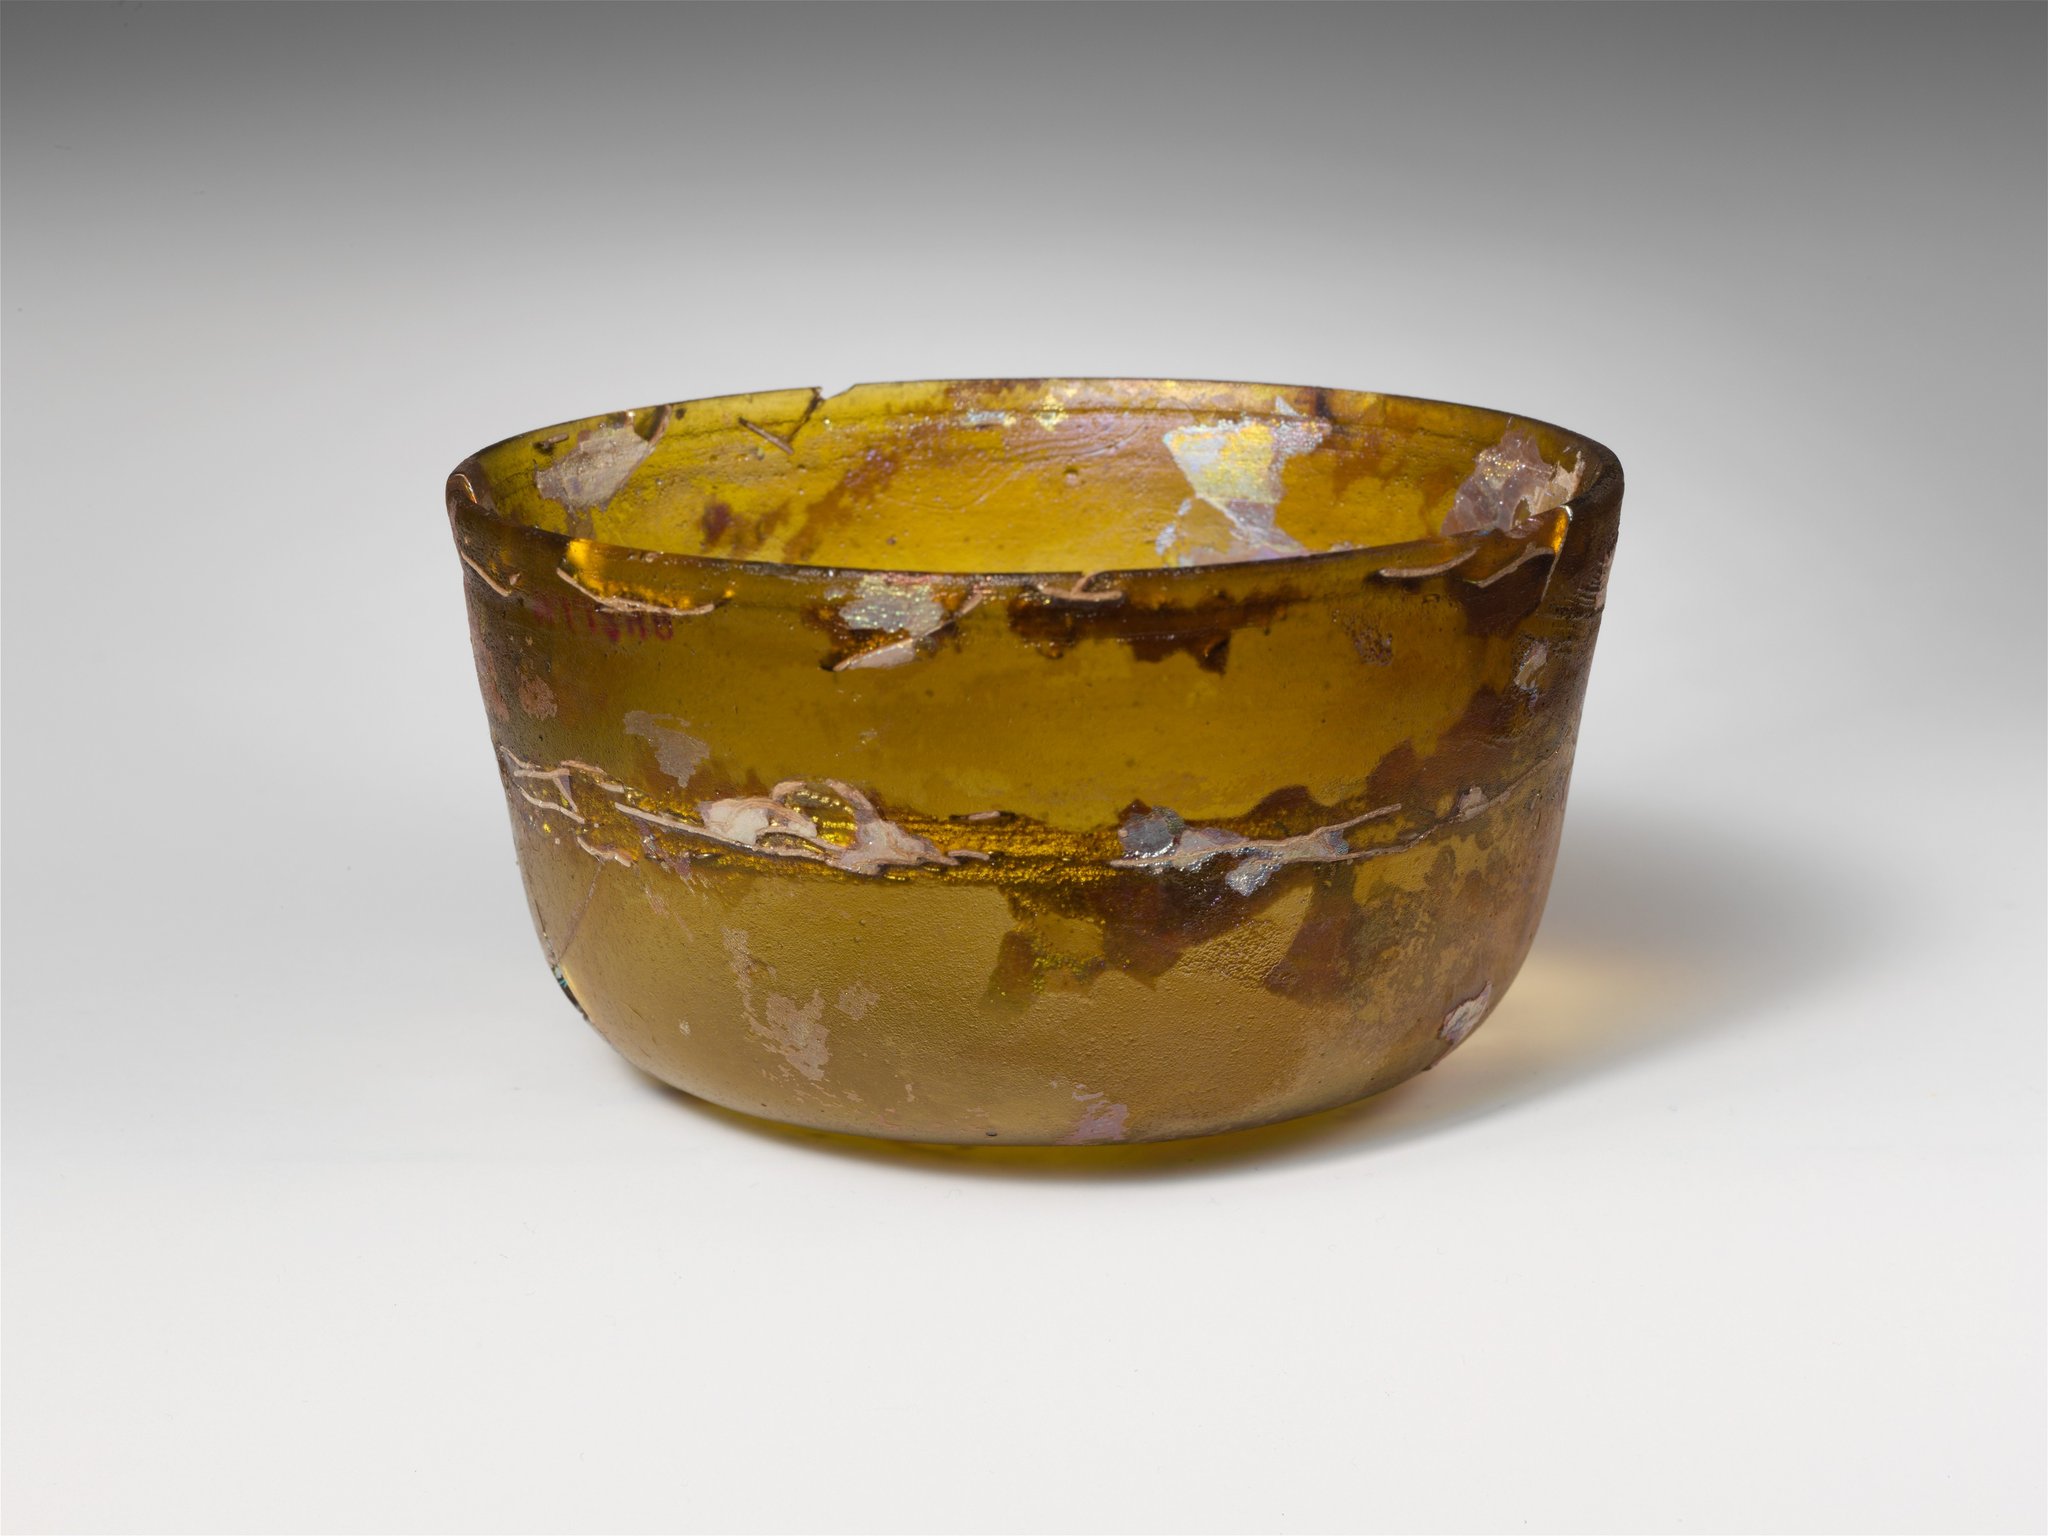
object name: bowl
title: Glass bowl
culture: roman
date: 34 BCE-33 CE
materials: glass